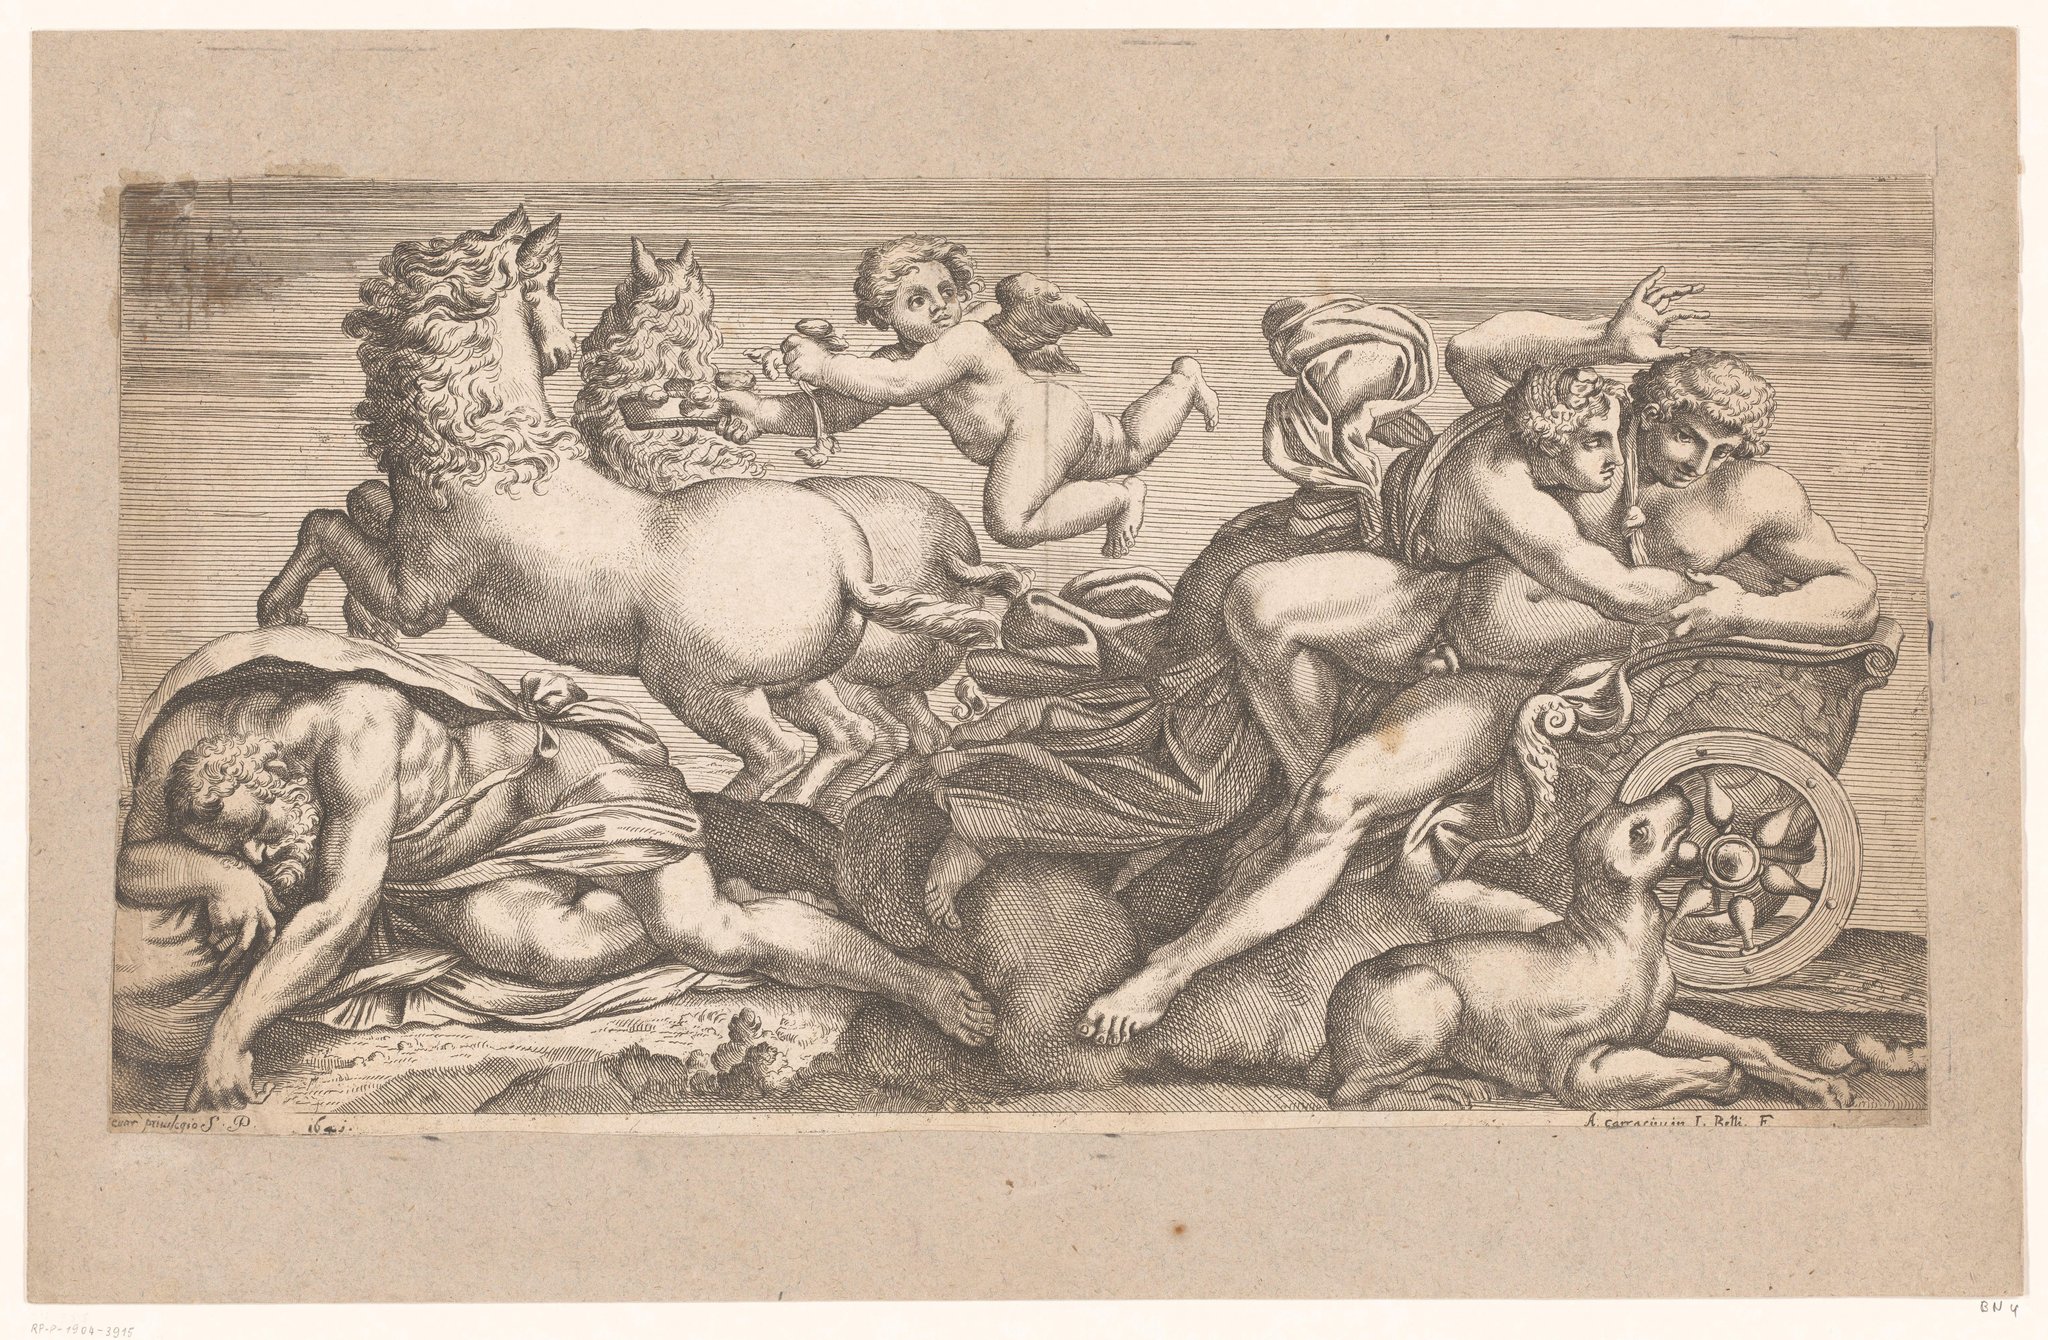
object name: print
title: Cephalus door Aurora meegenomen in haar strijdwagen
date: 1641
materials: paper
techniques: etching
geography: france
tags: aurora carrying off cephalus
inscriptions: collector's mark: Lugt 2228